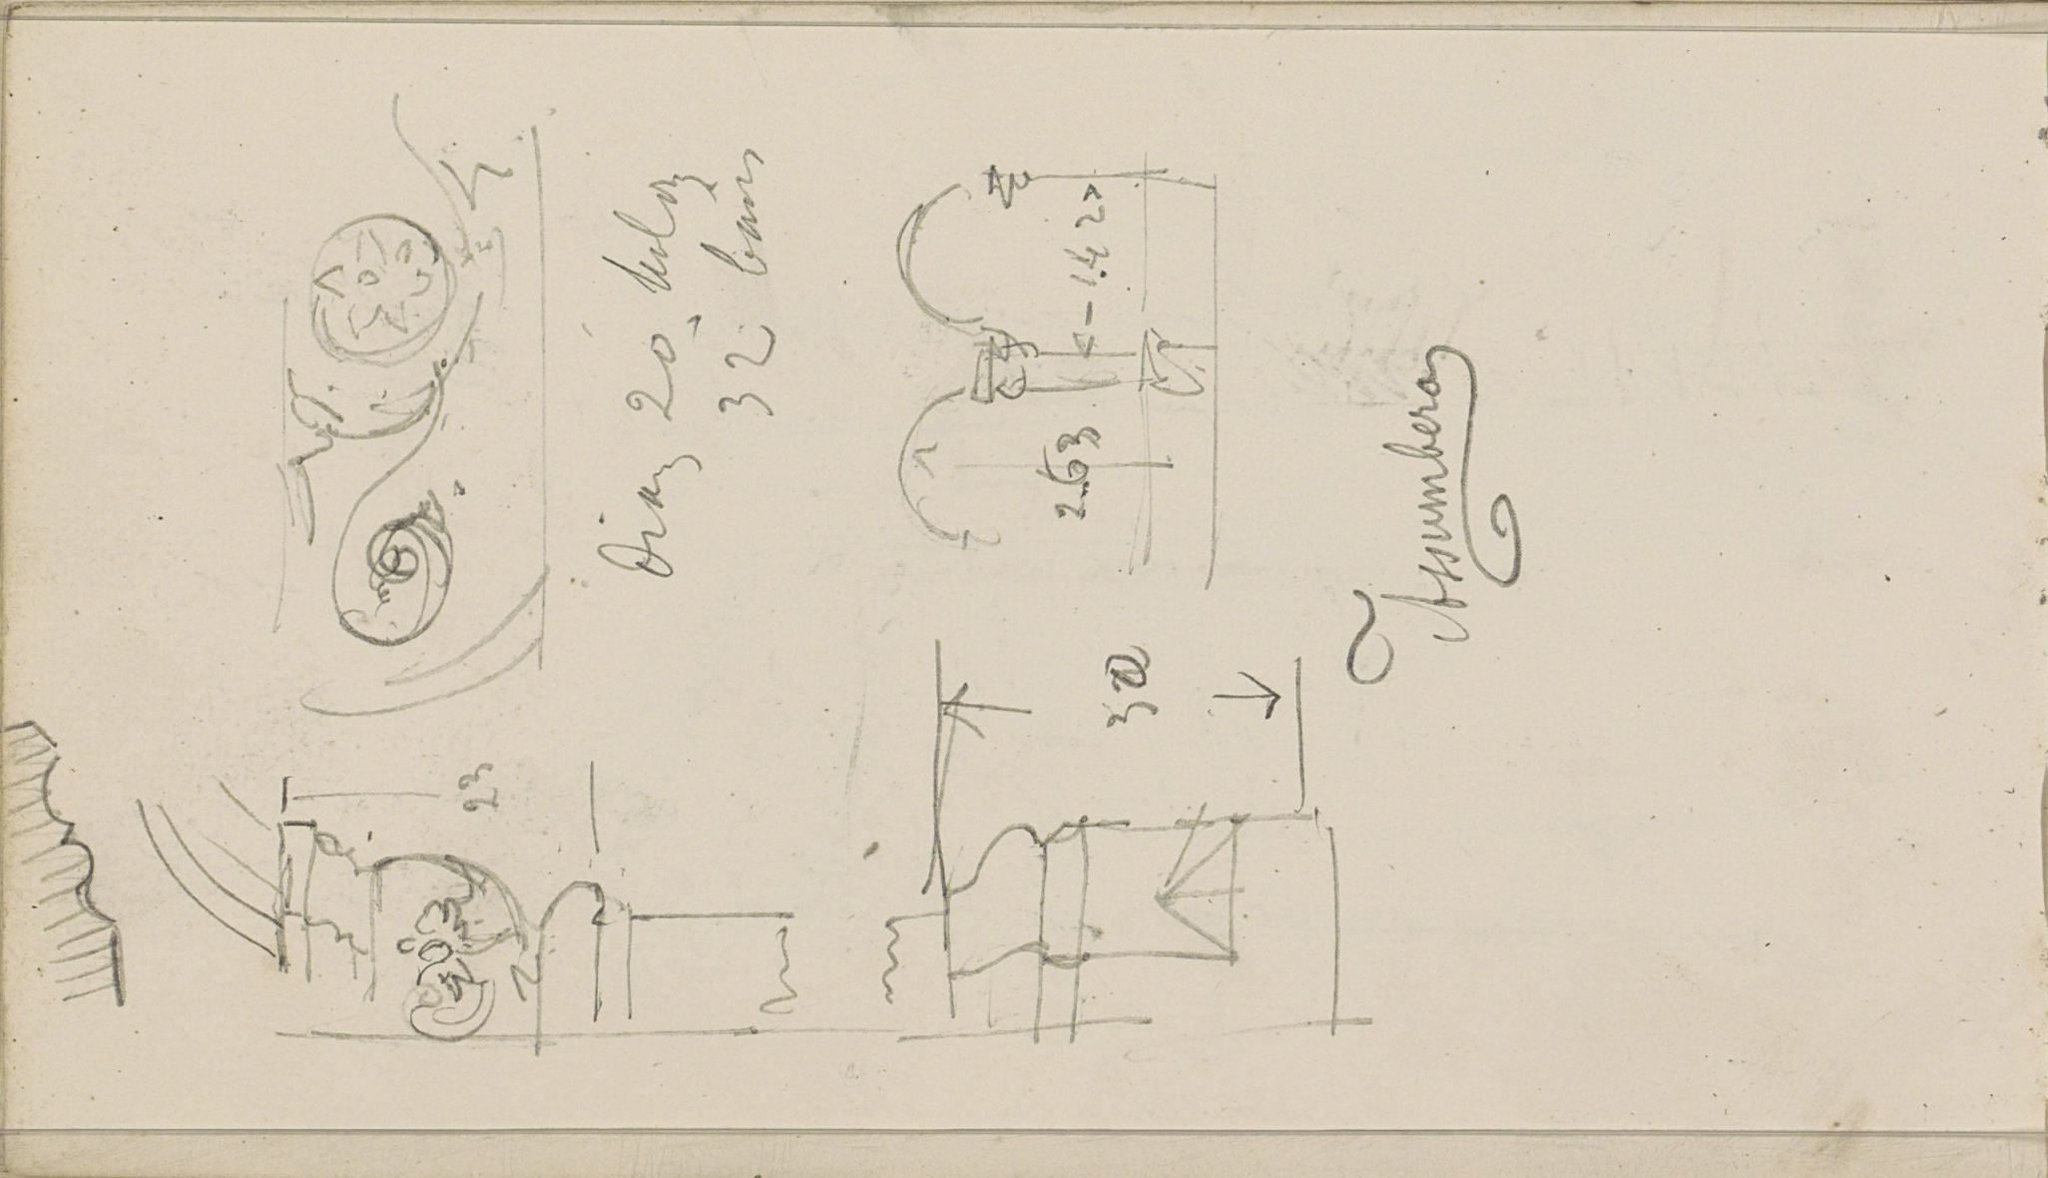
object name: sketchbook leaf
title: Details van de architectuur van Kasteel Assumburg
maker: isaac gosschalk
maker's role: draughtsman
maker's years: 1838-1907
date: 1866-1868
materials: paper, pencil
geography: heemskerk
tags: architectural detail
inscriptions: annotation: ‘[...]/ Assumberg’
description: Blad 64 verso uit een schetsboek met 67 bladen.